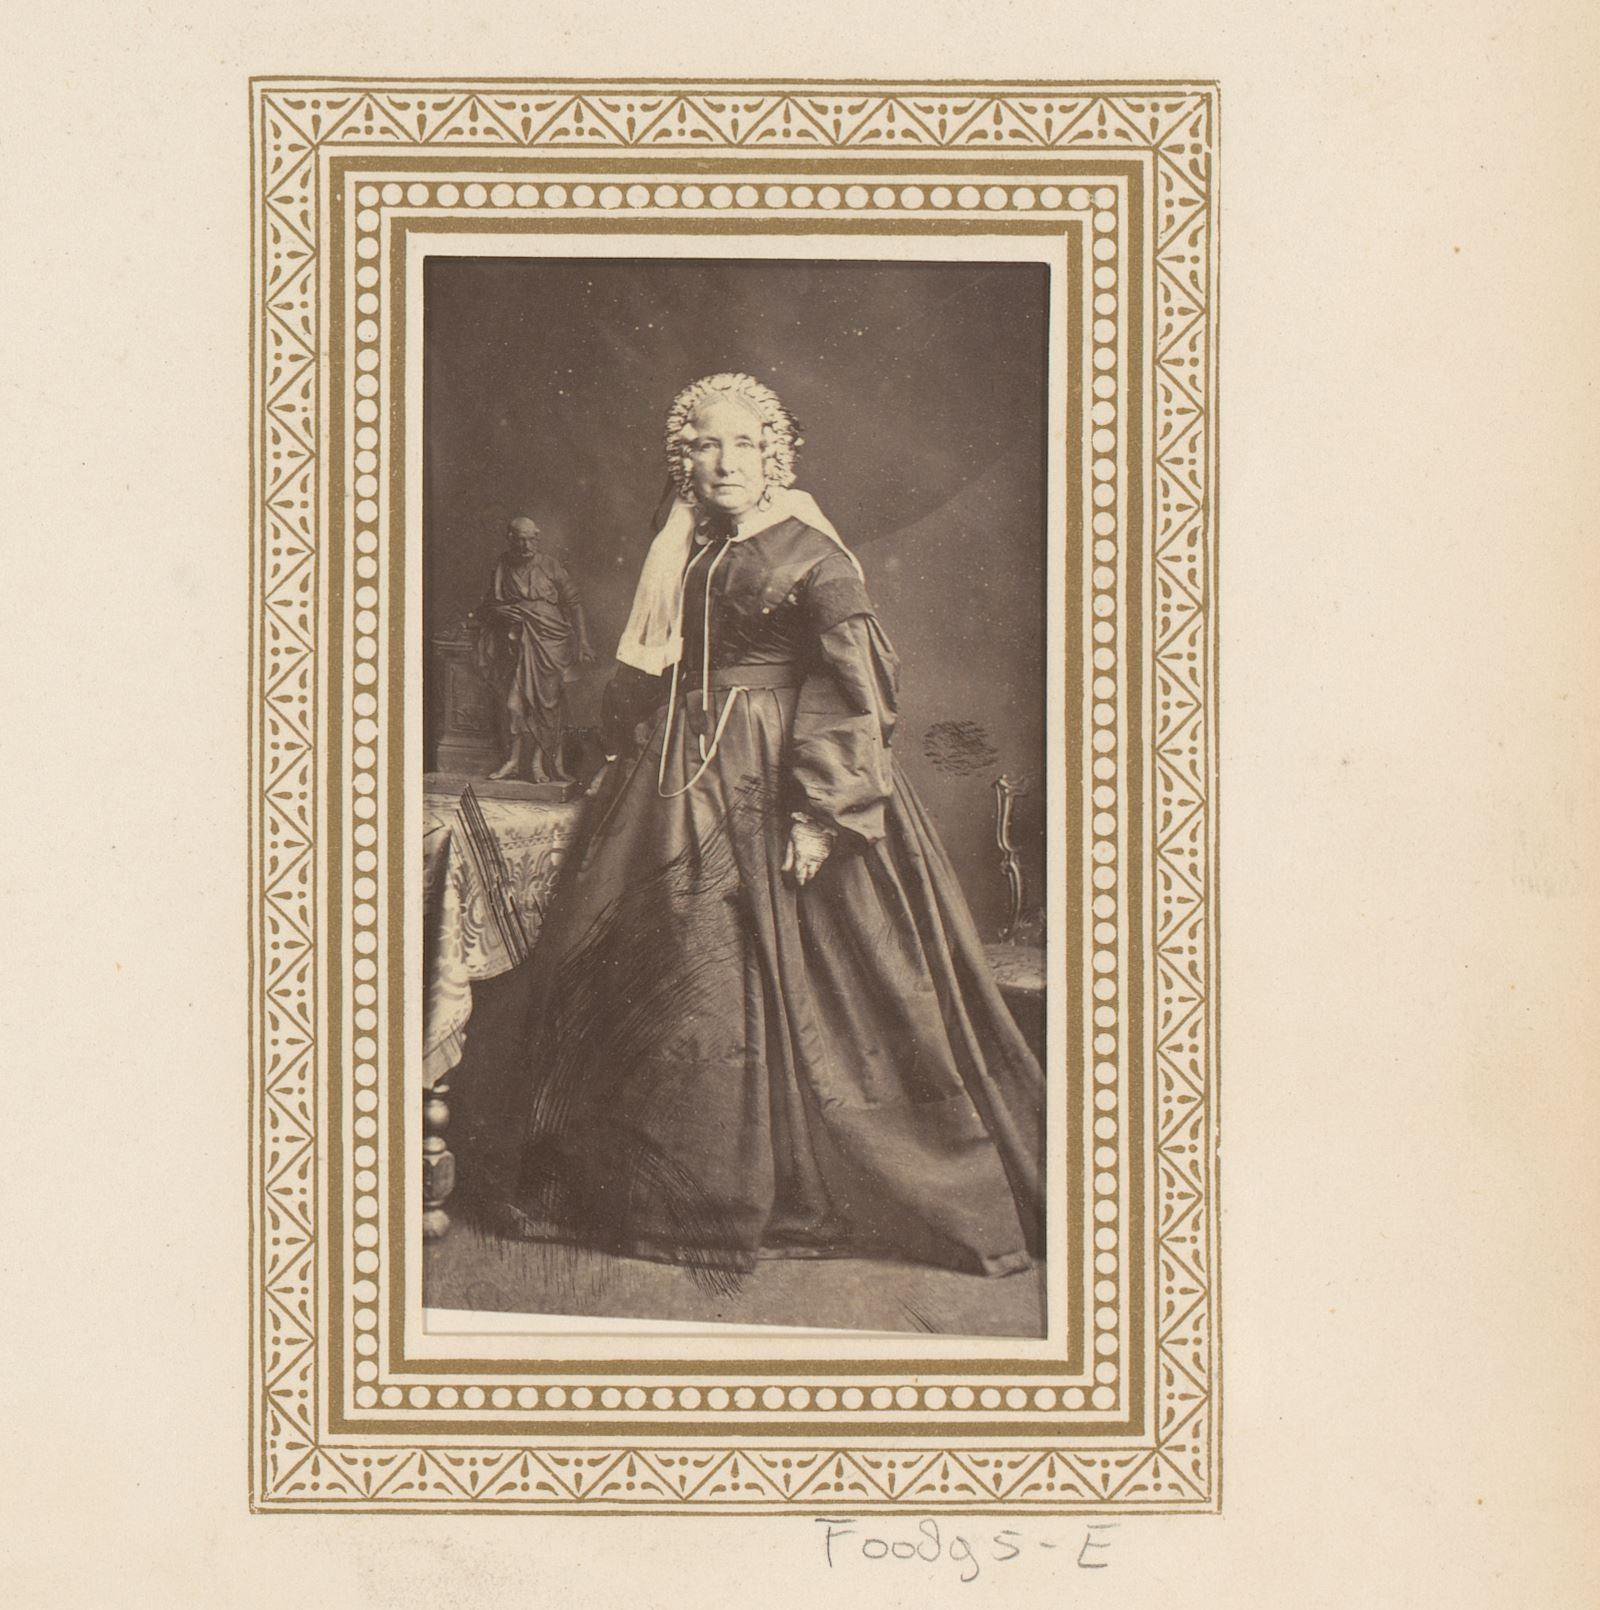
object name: carte de visite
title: Portret van een vrouw, staan bij een tafel met sculptuur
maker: george herbert watkins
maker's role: fotograaf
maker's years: 1828-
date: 1857-1872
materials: cardboard, photographic support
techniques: albumen print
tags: historical persons, head-gear: cap, standing figure - aa - female human figure, sculpture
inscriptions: inscription: ‘Semper Fidelis/ Photographed by/ Herbert Watkins/ 215 Regent Street/ London’